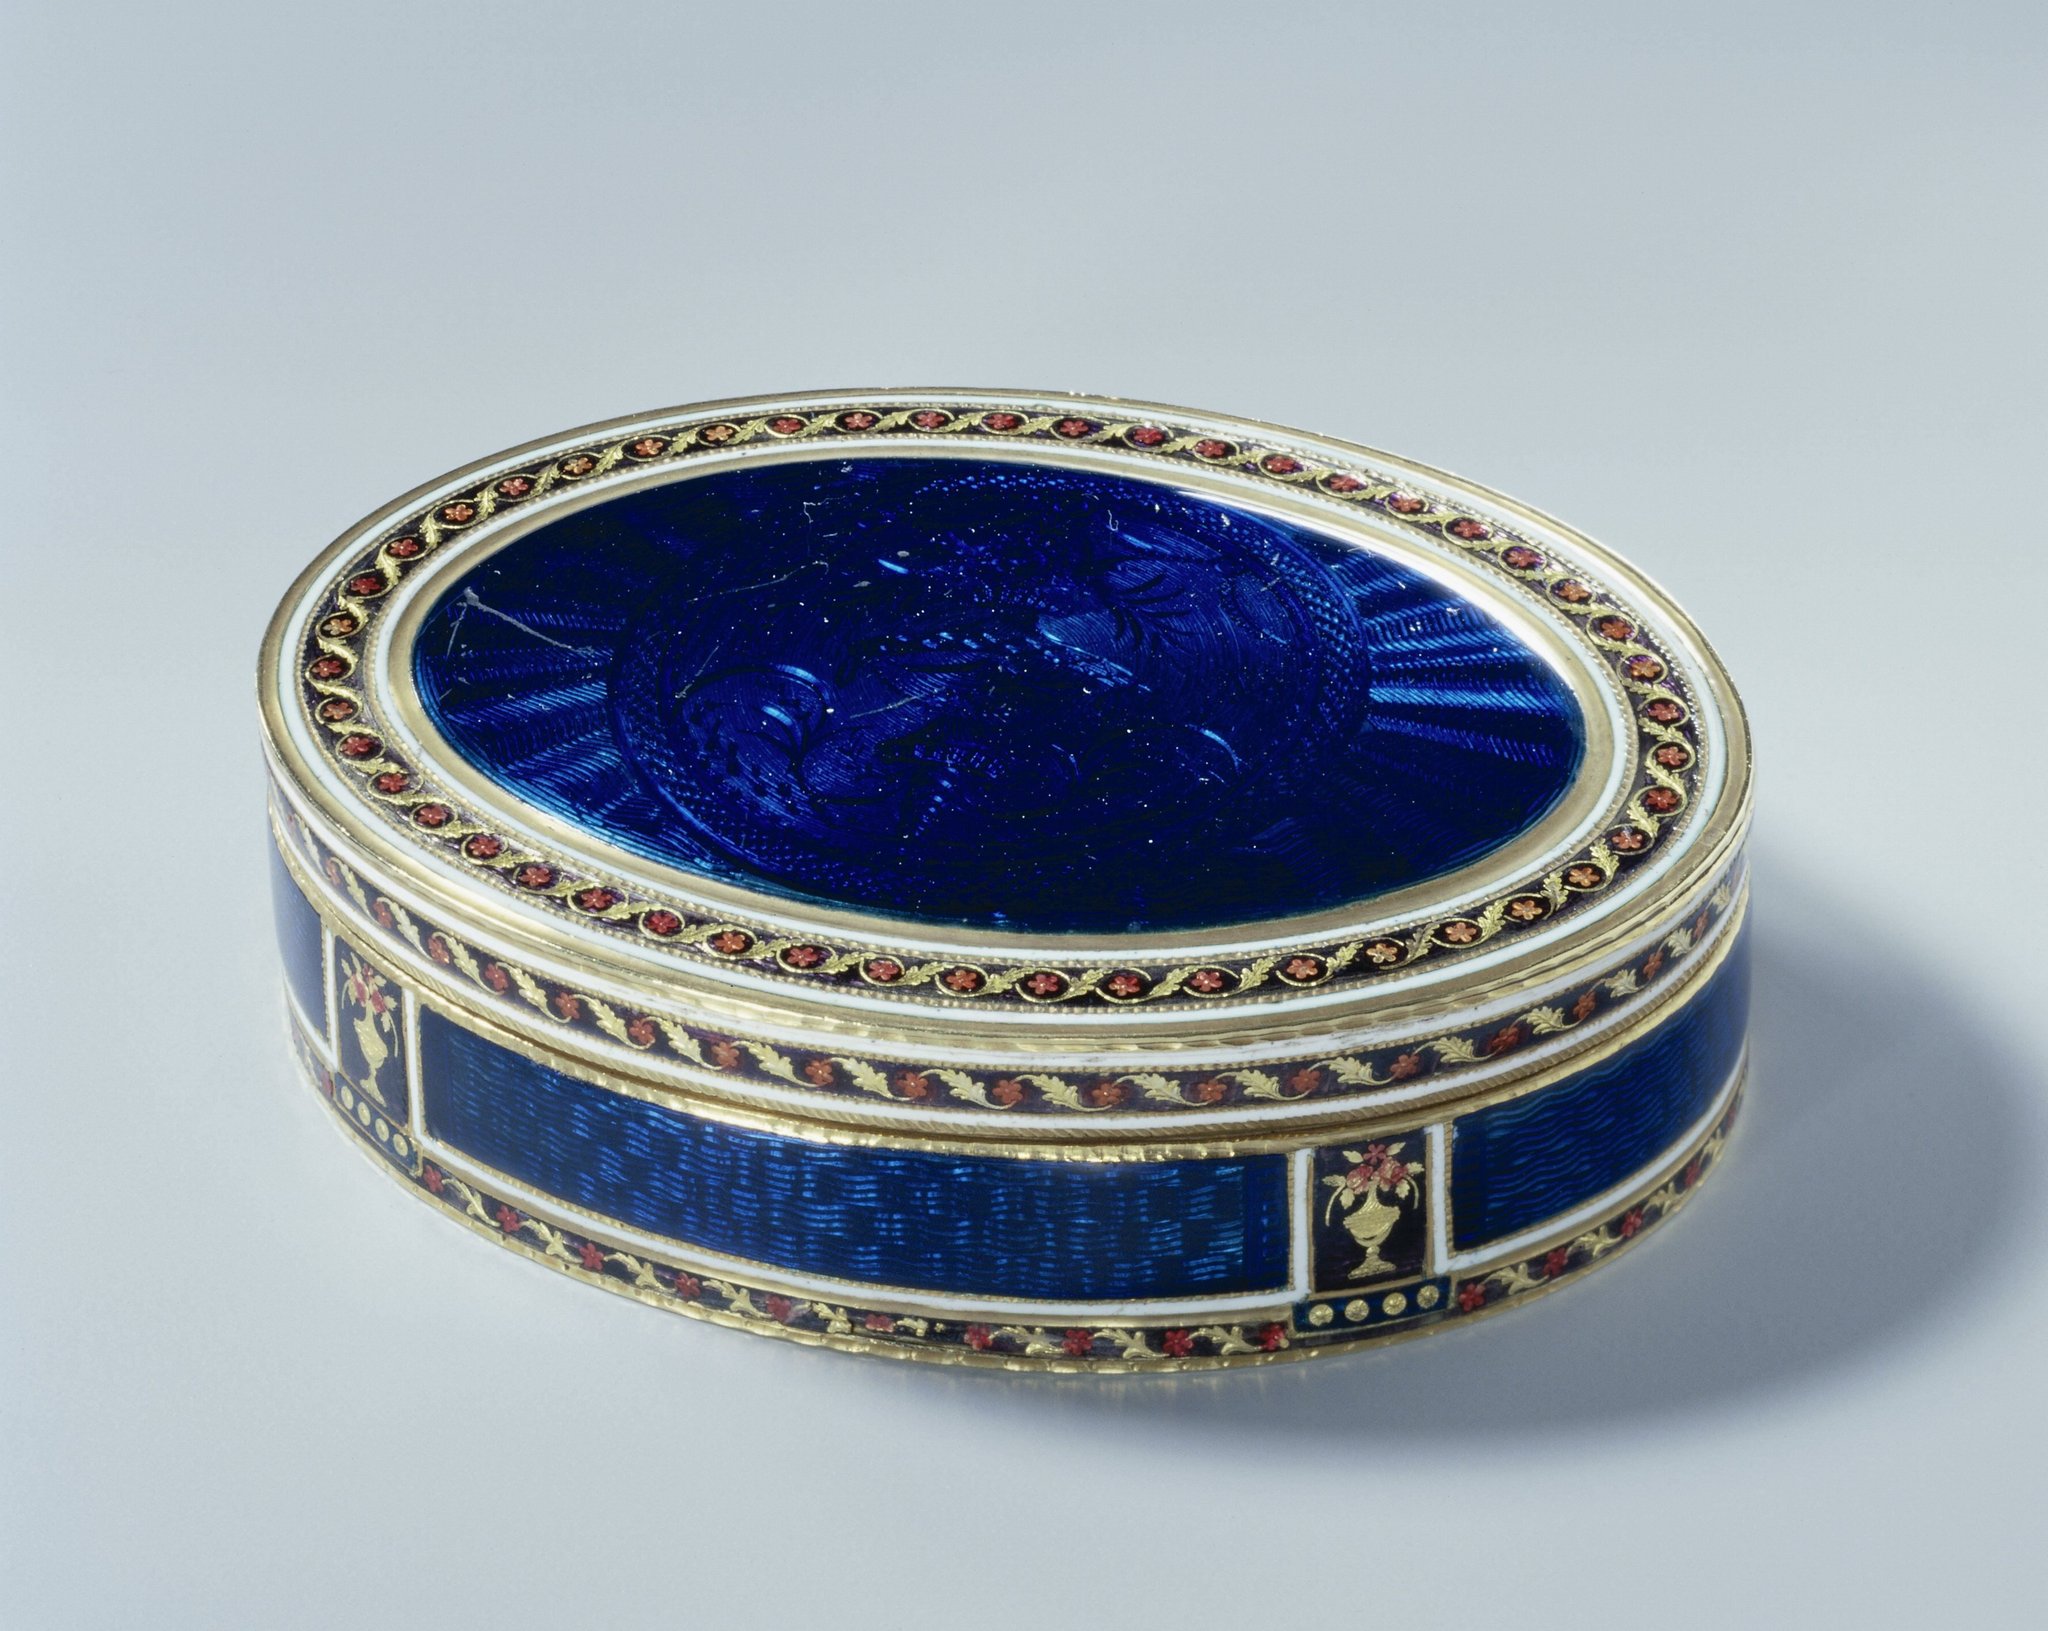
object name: snuffbox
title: Snuifdoos met blauwe, translucide email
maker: Anonymous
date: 1790-1800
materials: gold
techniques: enameling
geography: switzerland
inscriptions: mark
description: Ovale gouden snuifdoos met velden van blauwe, translucide email, afgezet met doorlopende gouden slingers met rode bloemen op paarsbruine fond. De geëmaillerde velden op de wand worden door vaasmotieven van elkaar gescheiden.